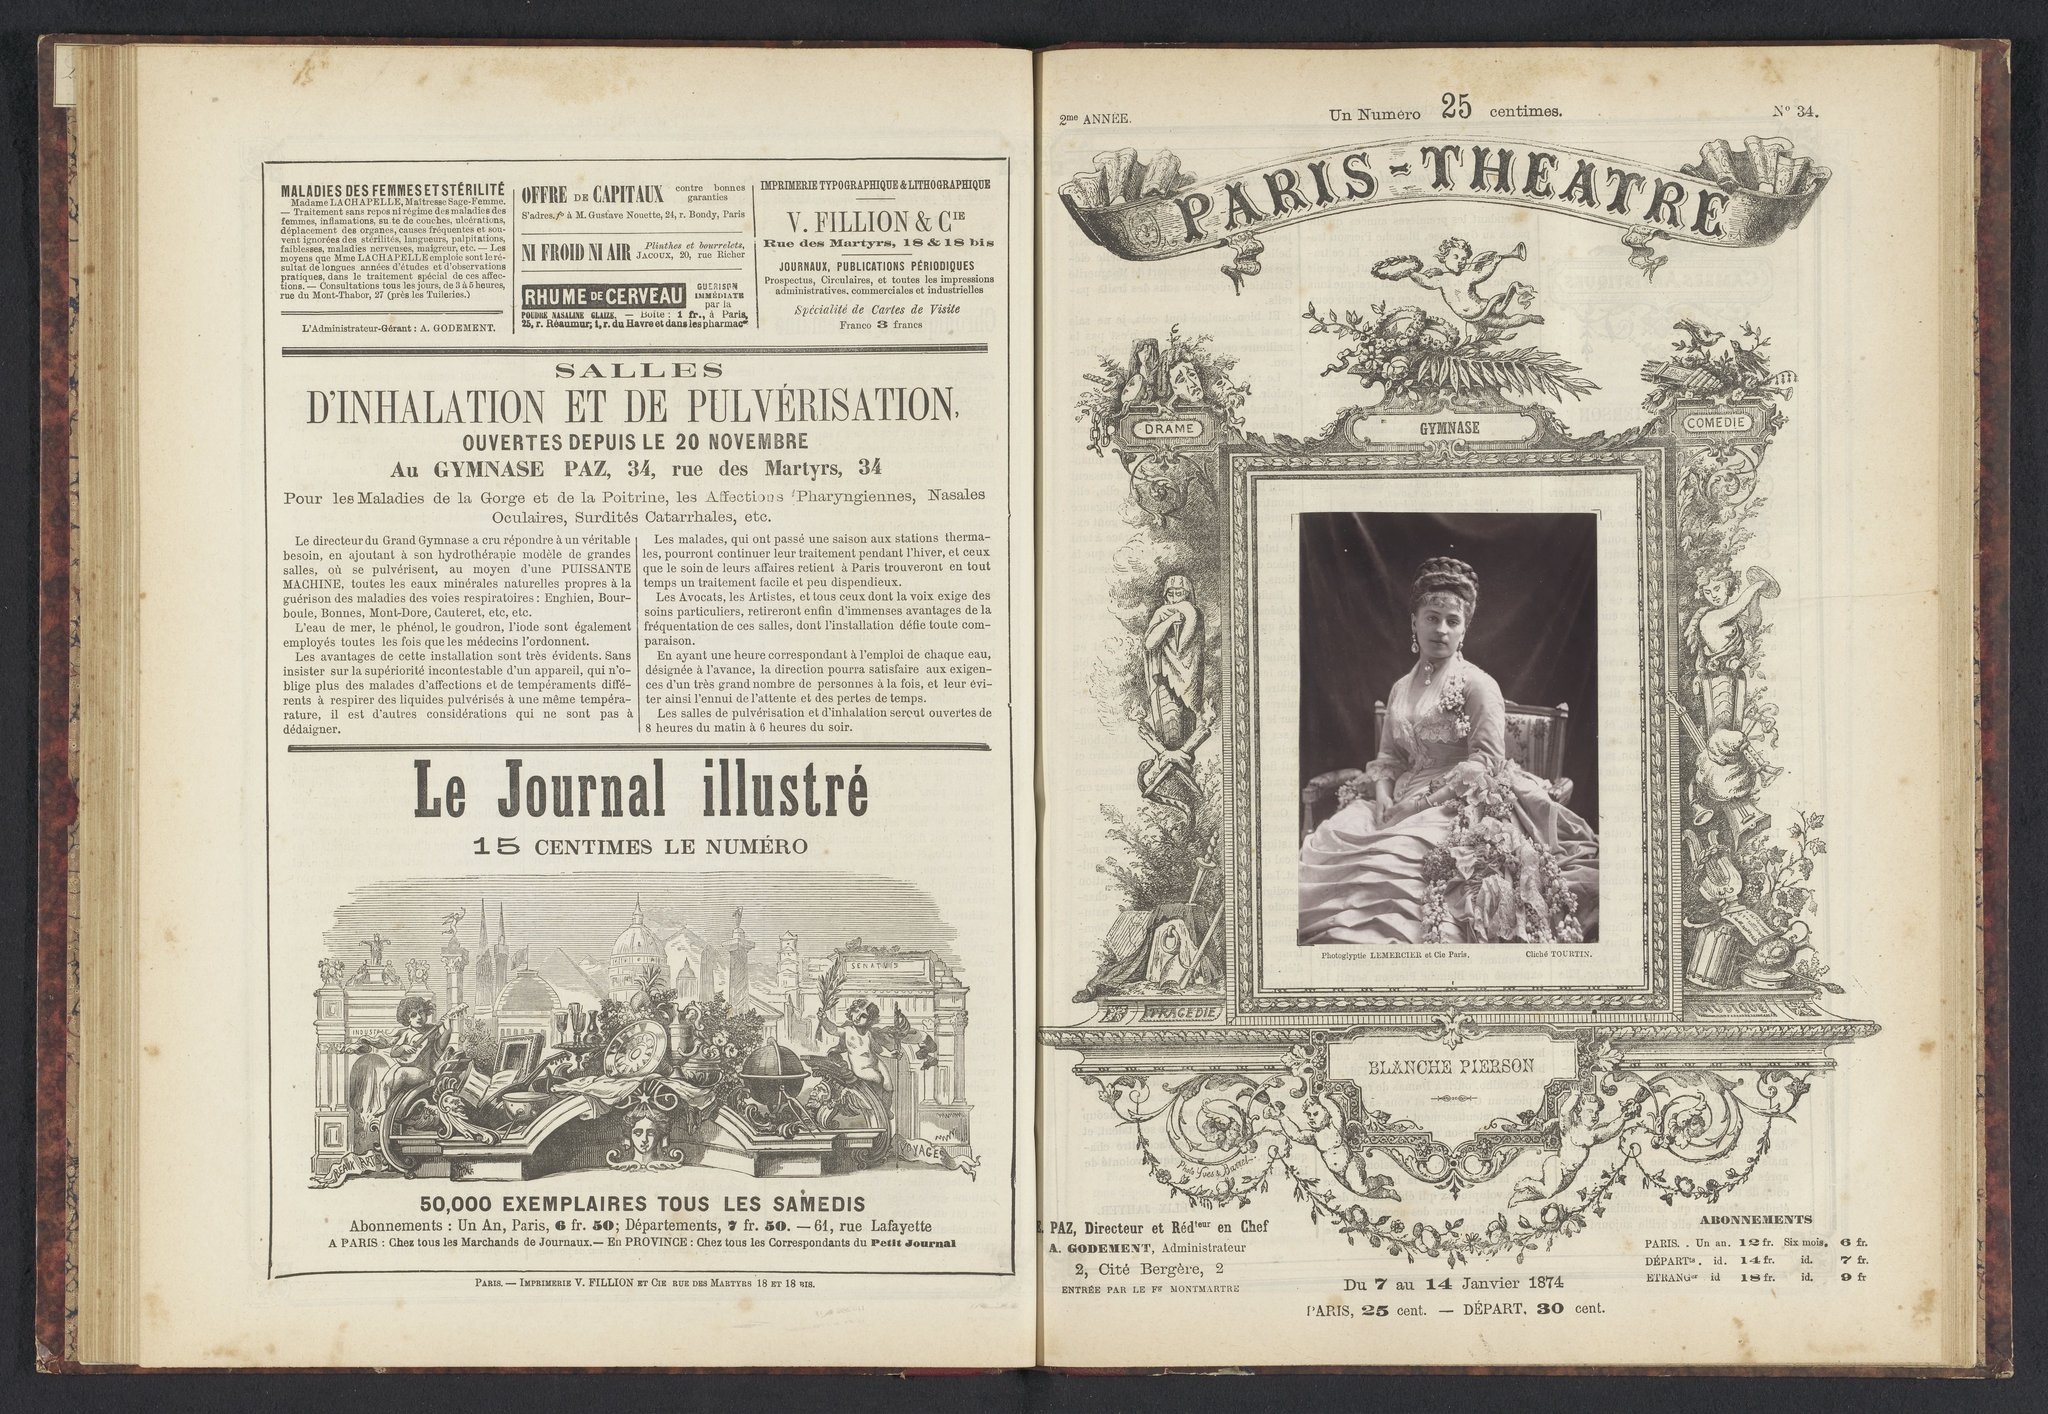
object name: page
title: Blanche Pierson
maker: emile tourtin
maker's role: fotograaf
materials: paper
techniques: woodburytype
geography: france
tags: portrait of opera-singer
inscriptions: number: ‘No 34.’, inscription: ‘Du 7 au 14 Janvier 1874’